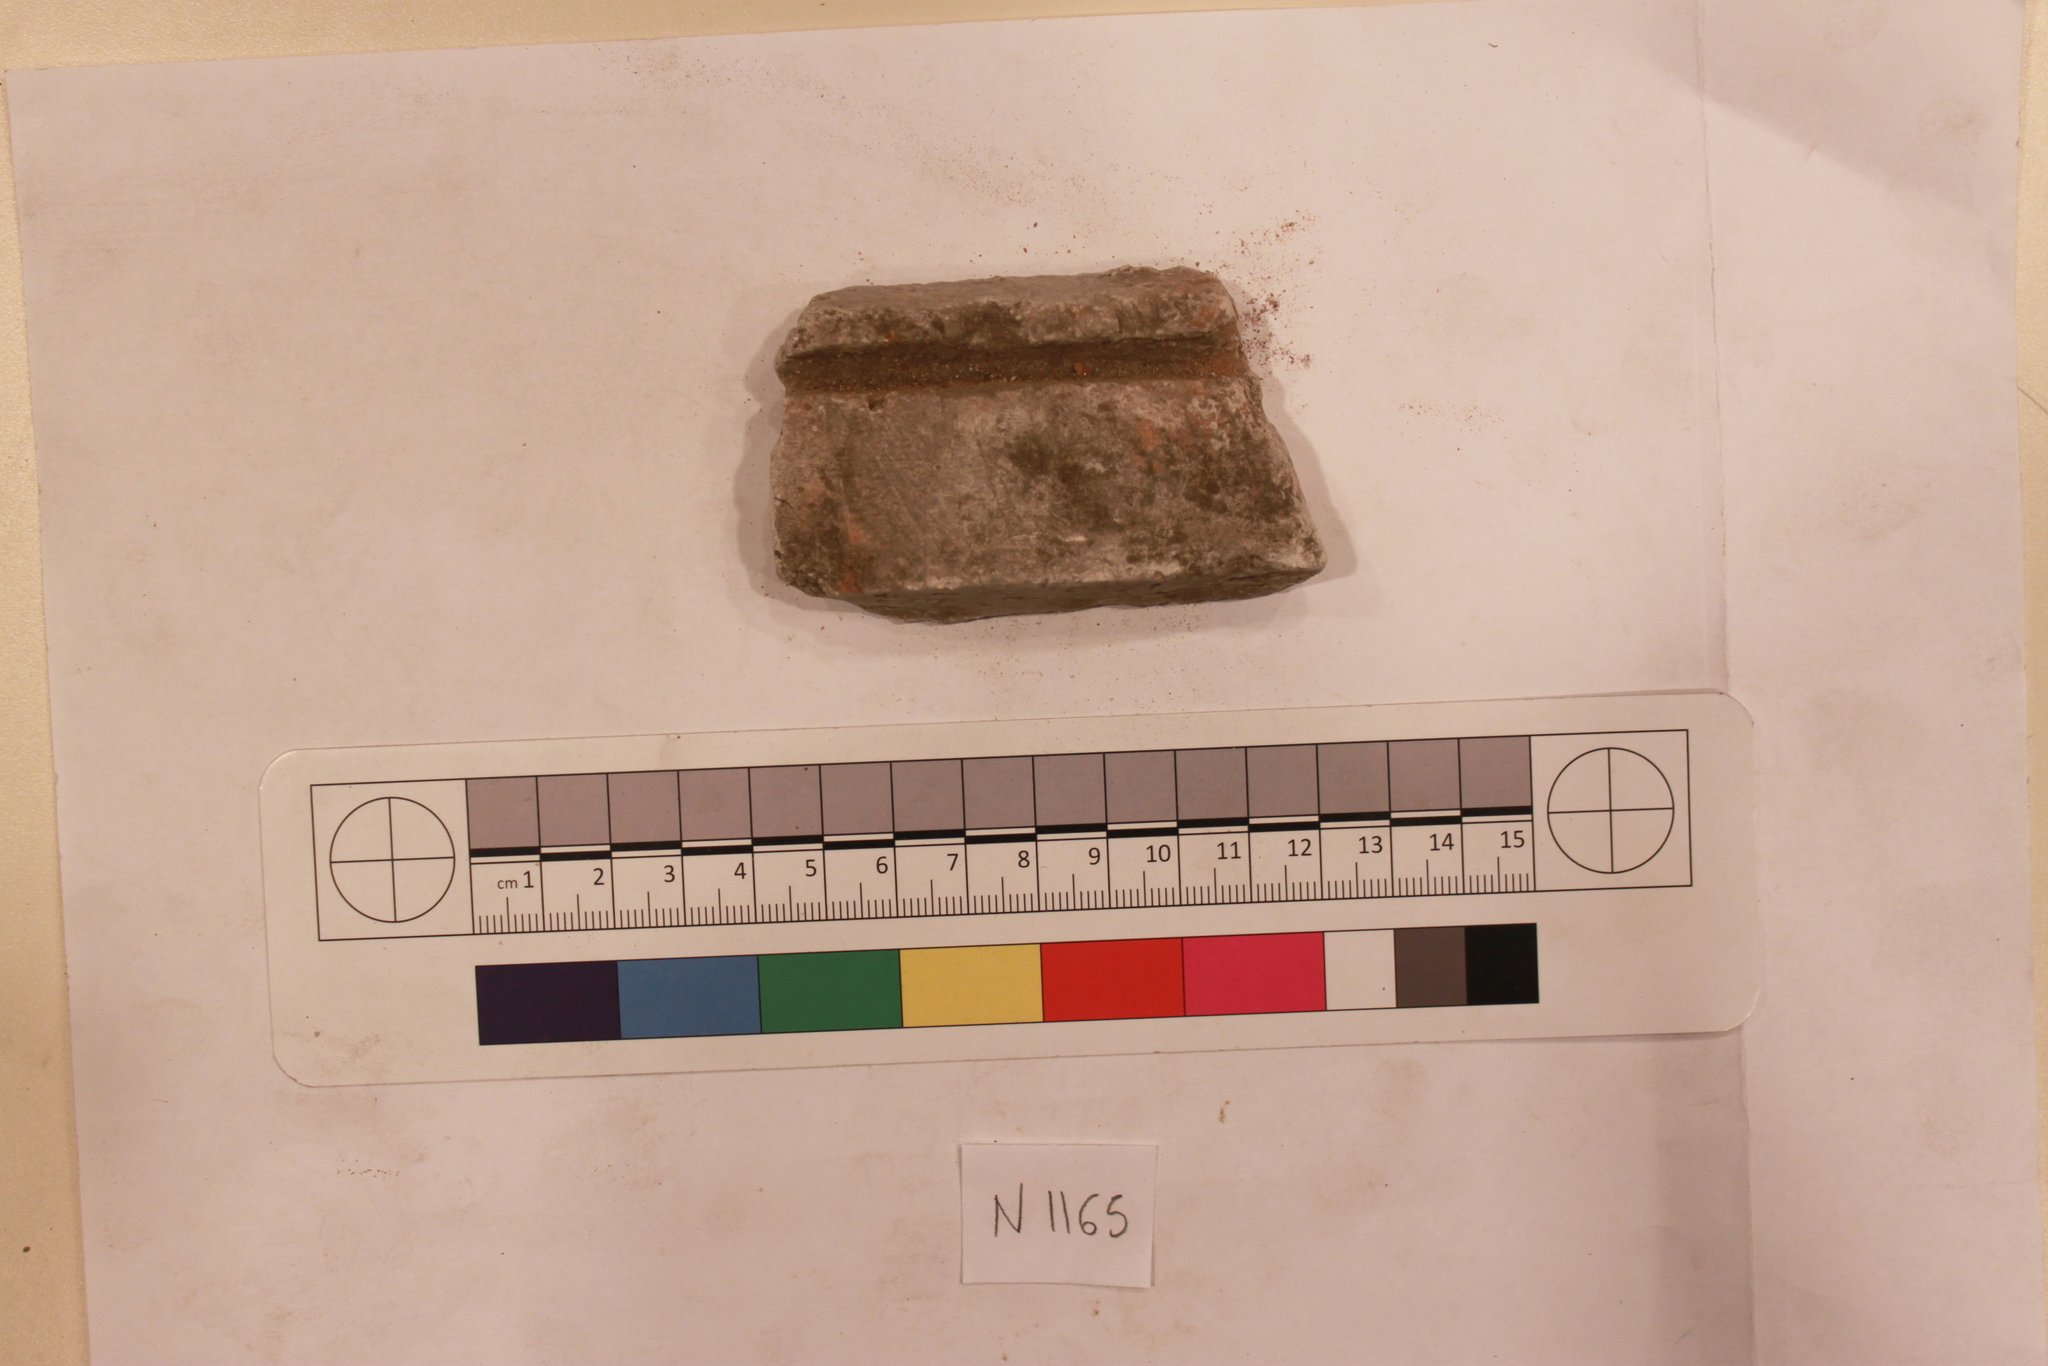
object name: fragment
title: Stucco Fragment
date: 701-1200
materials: plaster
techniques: carving, painting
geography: iran